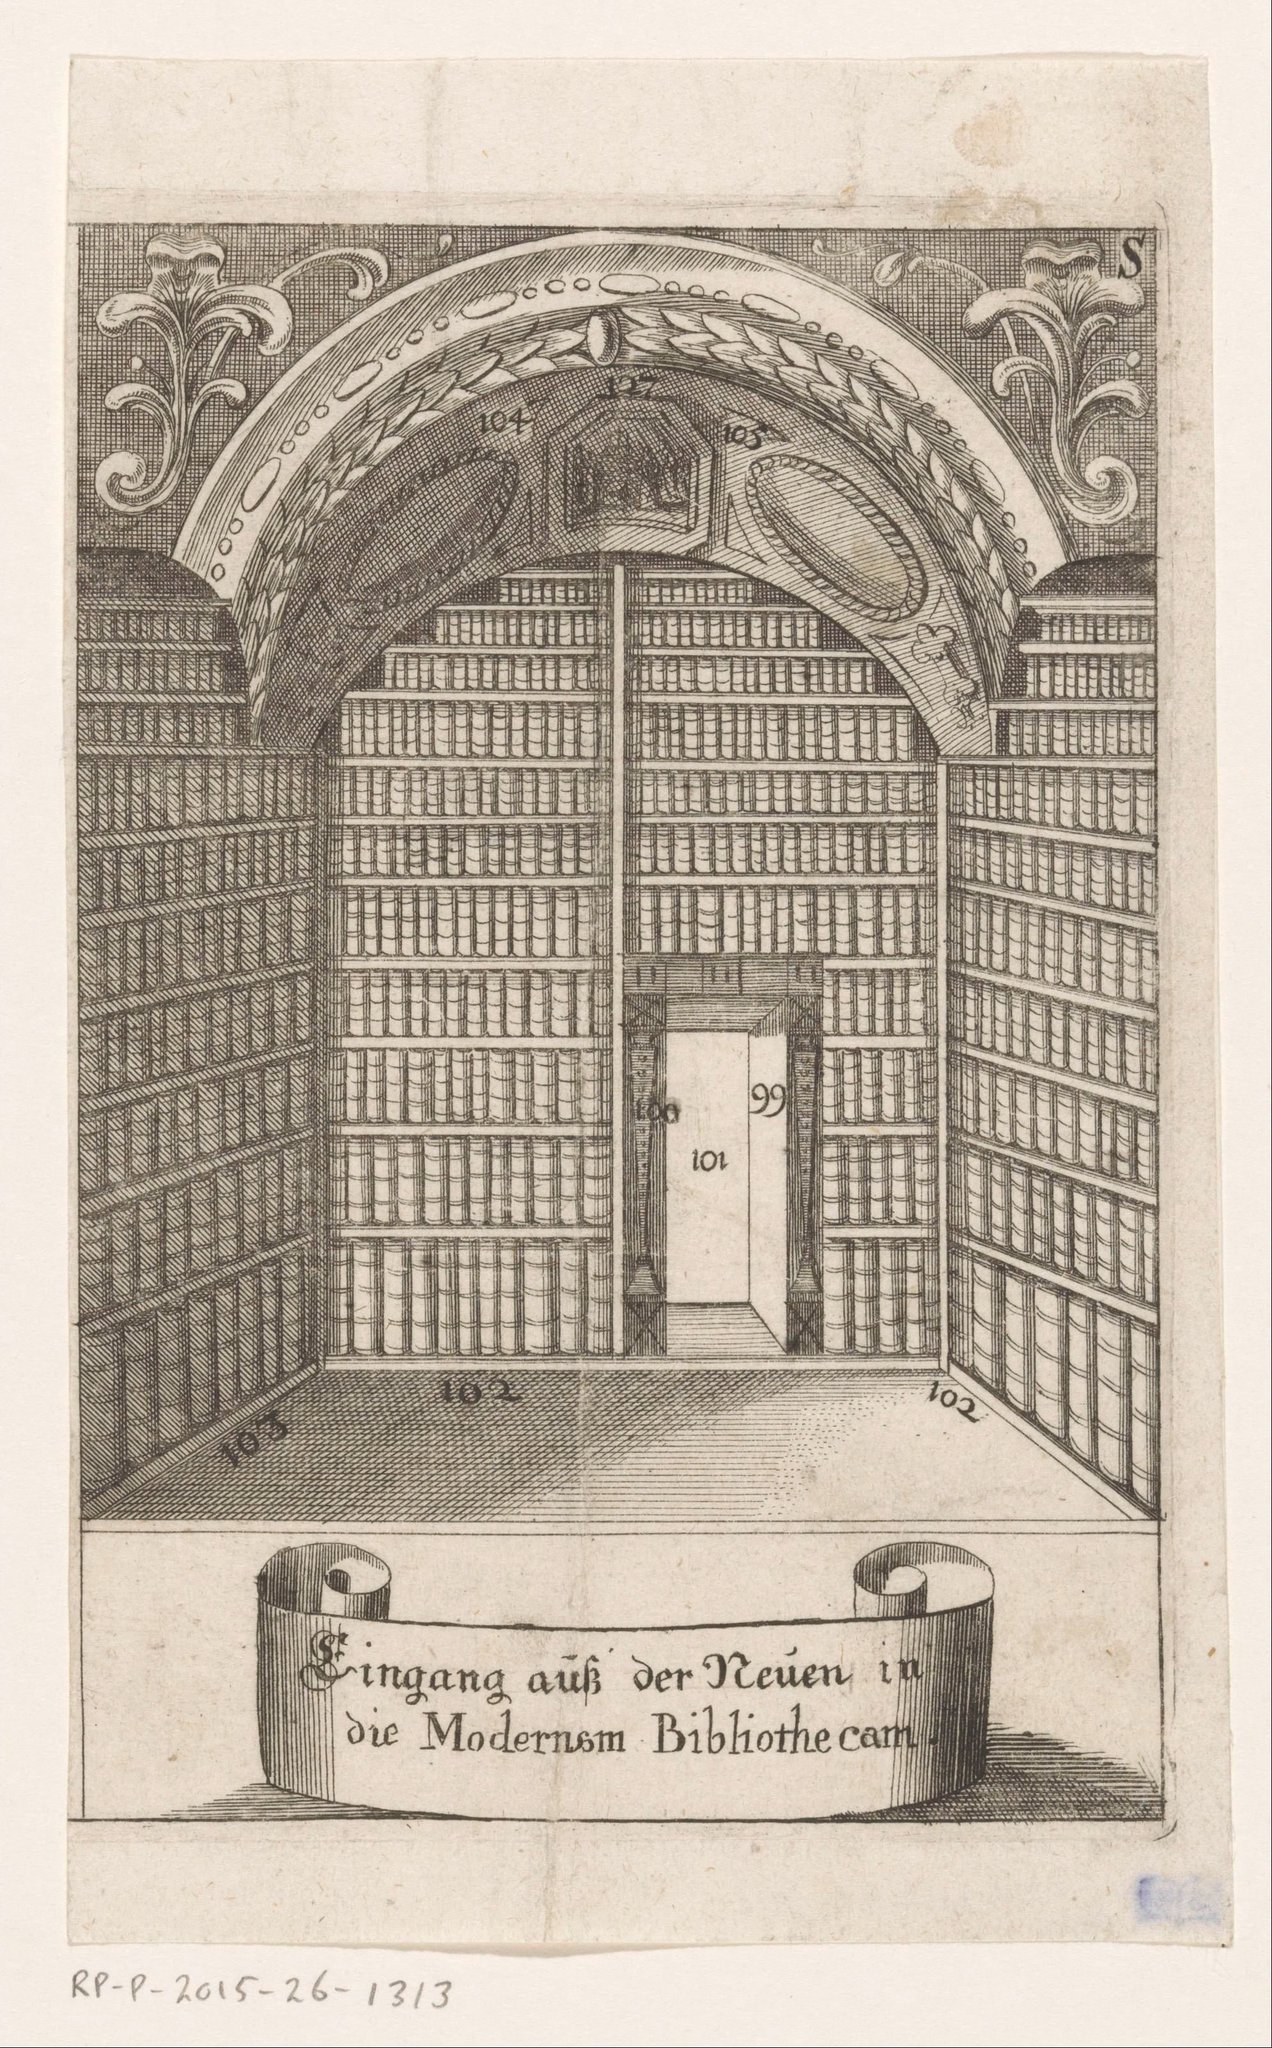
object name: print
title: Eingang aus der Neuen in die Modernem Bibliothecam.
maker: Anonymous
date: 1700-1799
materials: paper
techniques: etching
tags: bookshelves, public library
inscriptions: collector's mark: Lugt 2228, collector's mark: Lugt 4780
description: Bibliotheek met in een wand een deur en een gedecoreerd plafond. Rechtsboven genummerd: S.